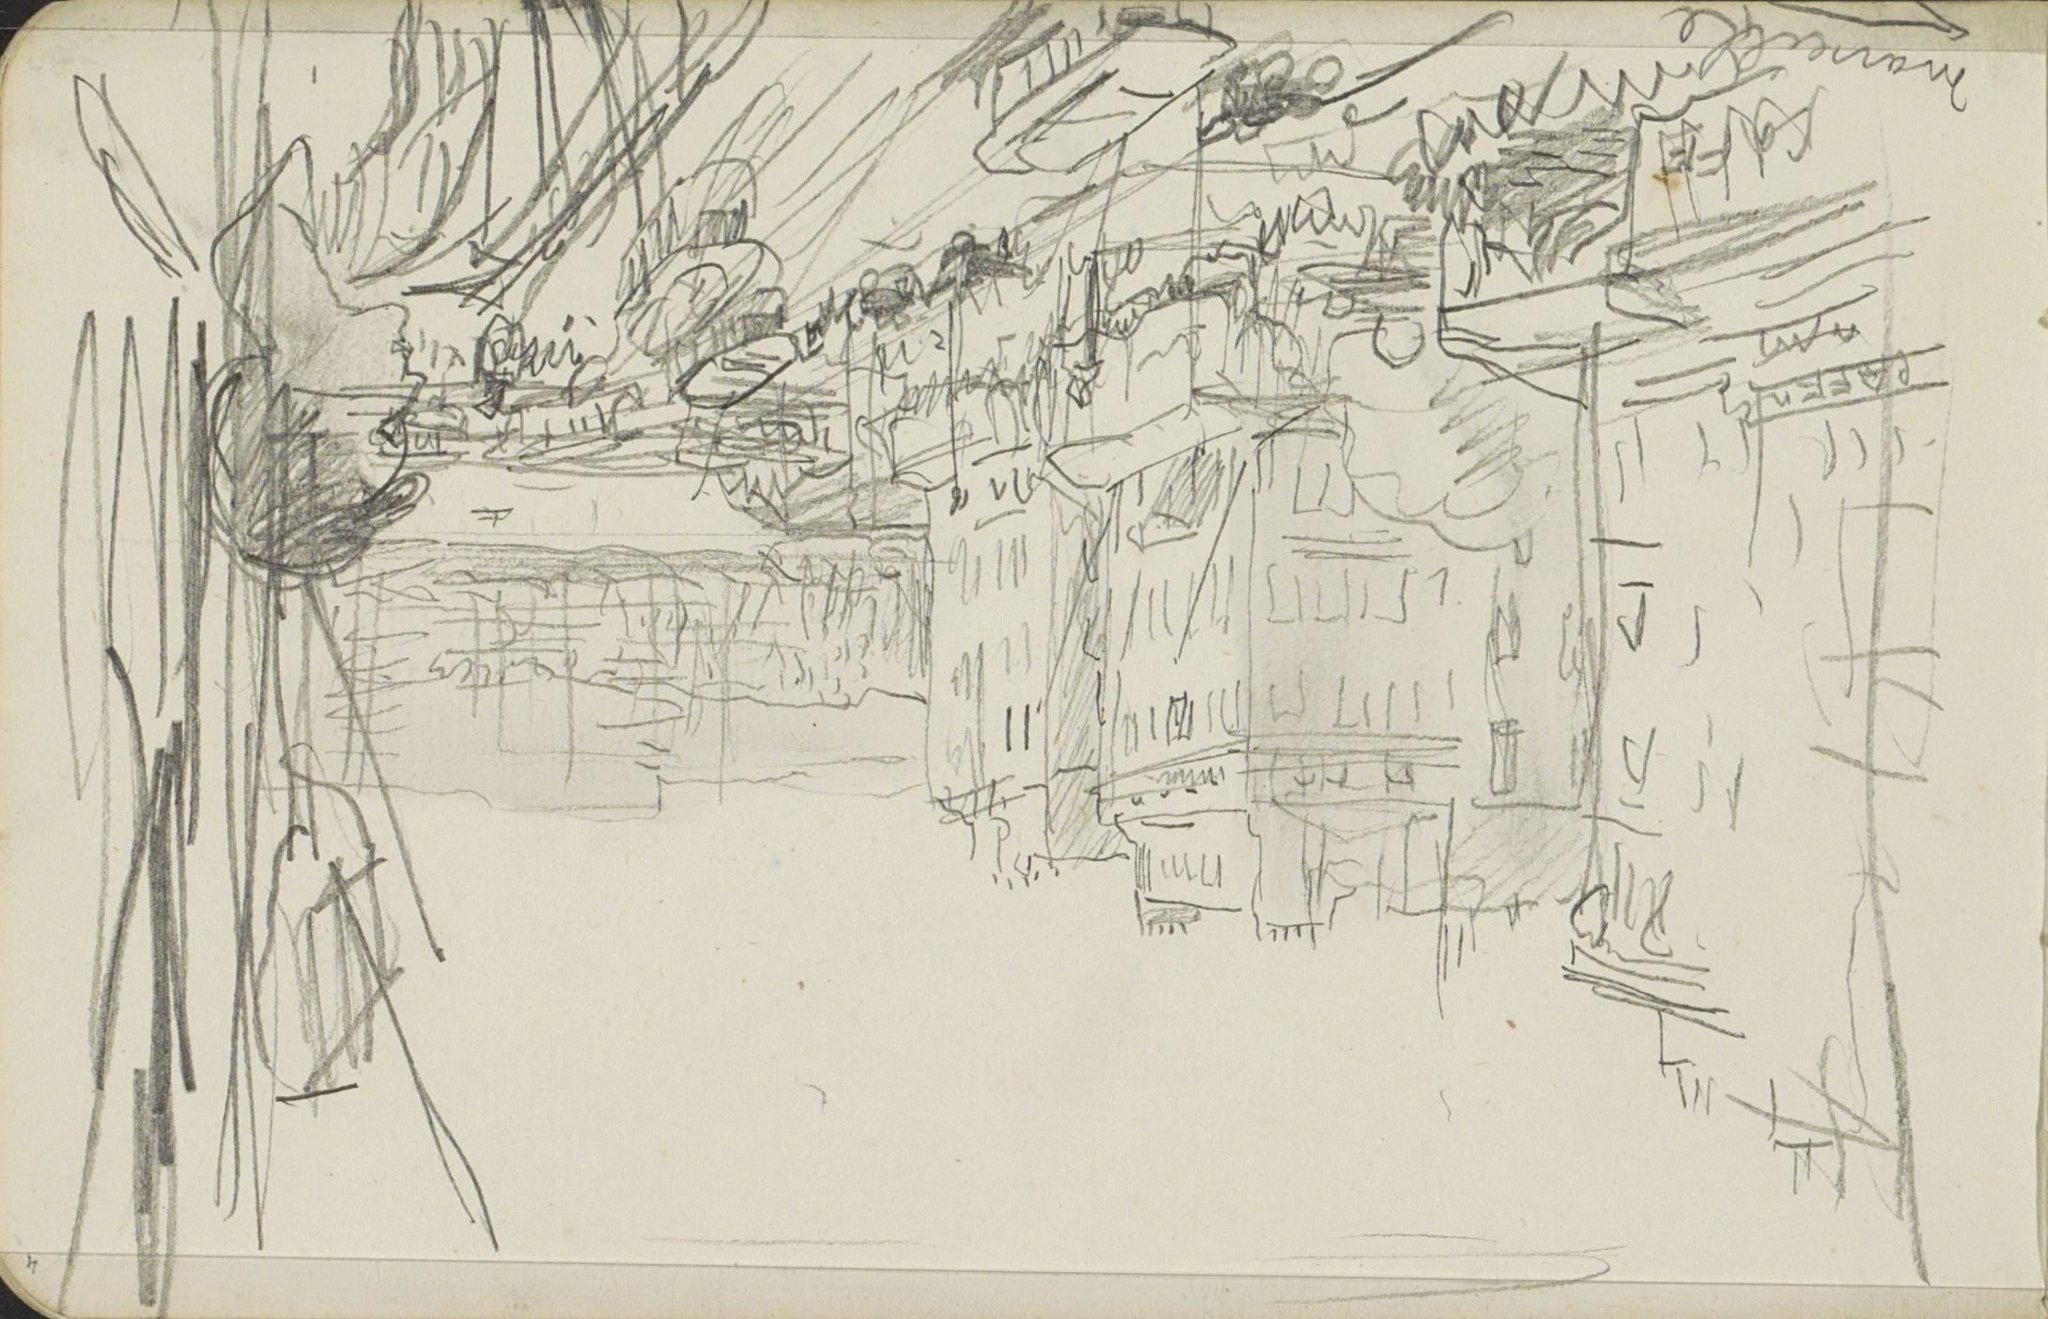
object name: sketchbook leaf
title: Gezicht op een straat in Marseille vanaf een balkon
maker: marius bauer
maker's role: draughtsman, print maker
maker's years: 1867-1932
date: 1902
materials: paper, pencil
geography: marseille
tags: standing figure, adult woman, balcony, street (+ city(-scape) with figures, staffage), marseille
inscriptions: annotation: ‘Marseille’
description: Op de voorgrond een vrouw, vermoedelijk Jo Bauer-Stumpff, op het balkon. Bauer en zijn vrouw waren in 1902 op huwelijksreis in Frankrijk en Spanje. Pagina 4 uit een schetsboek met 15 bladen.